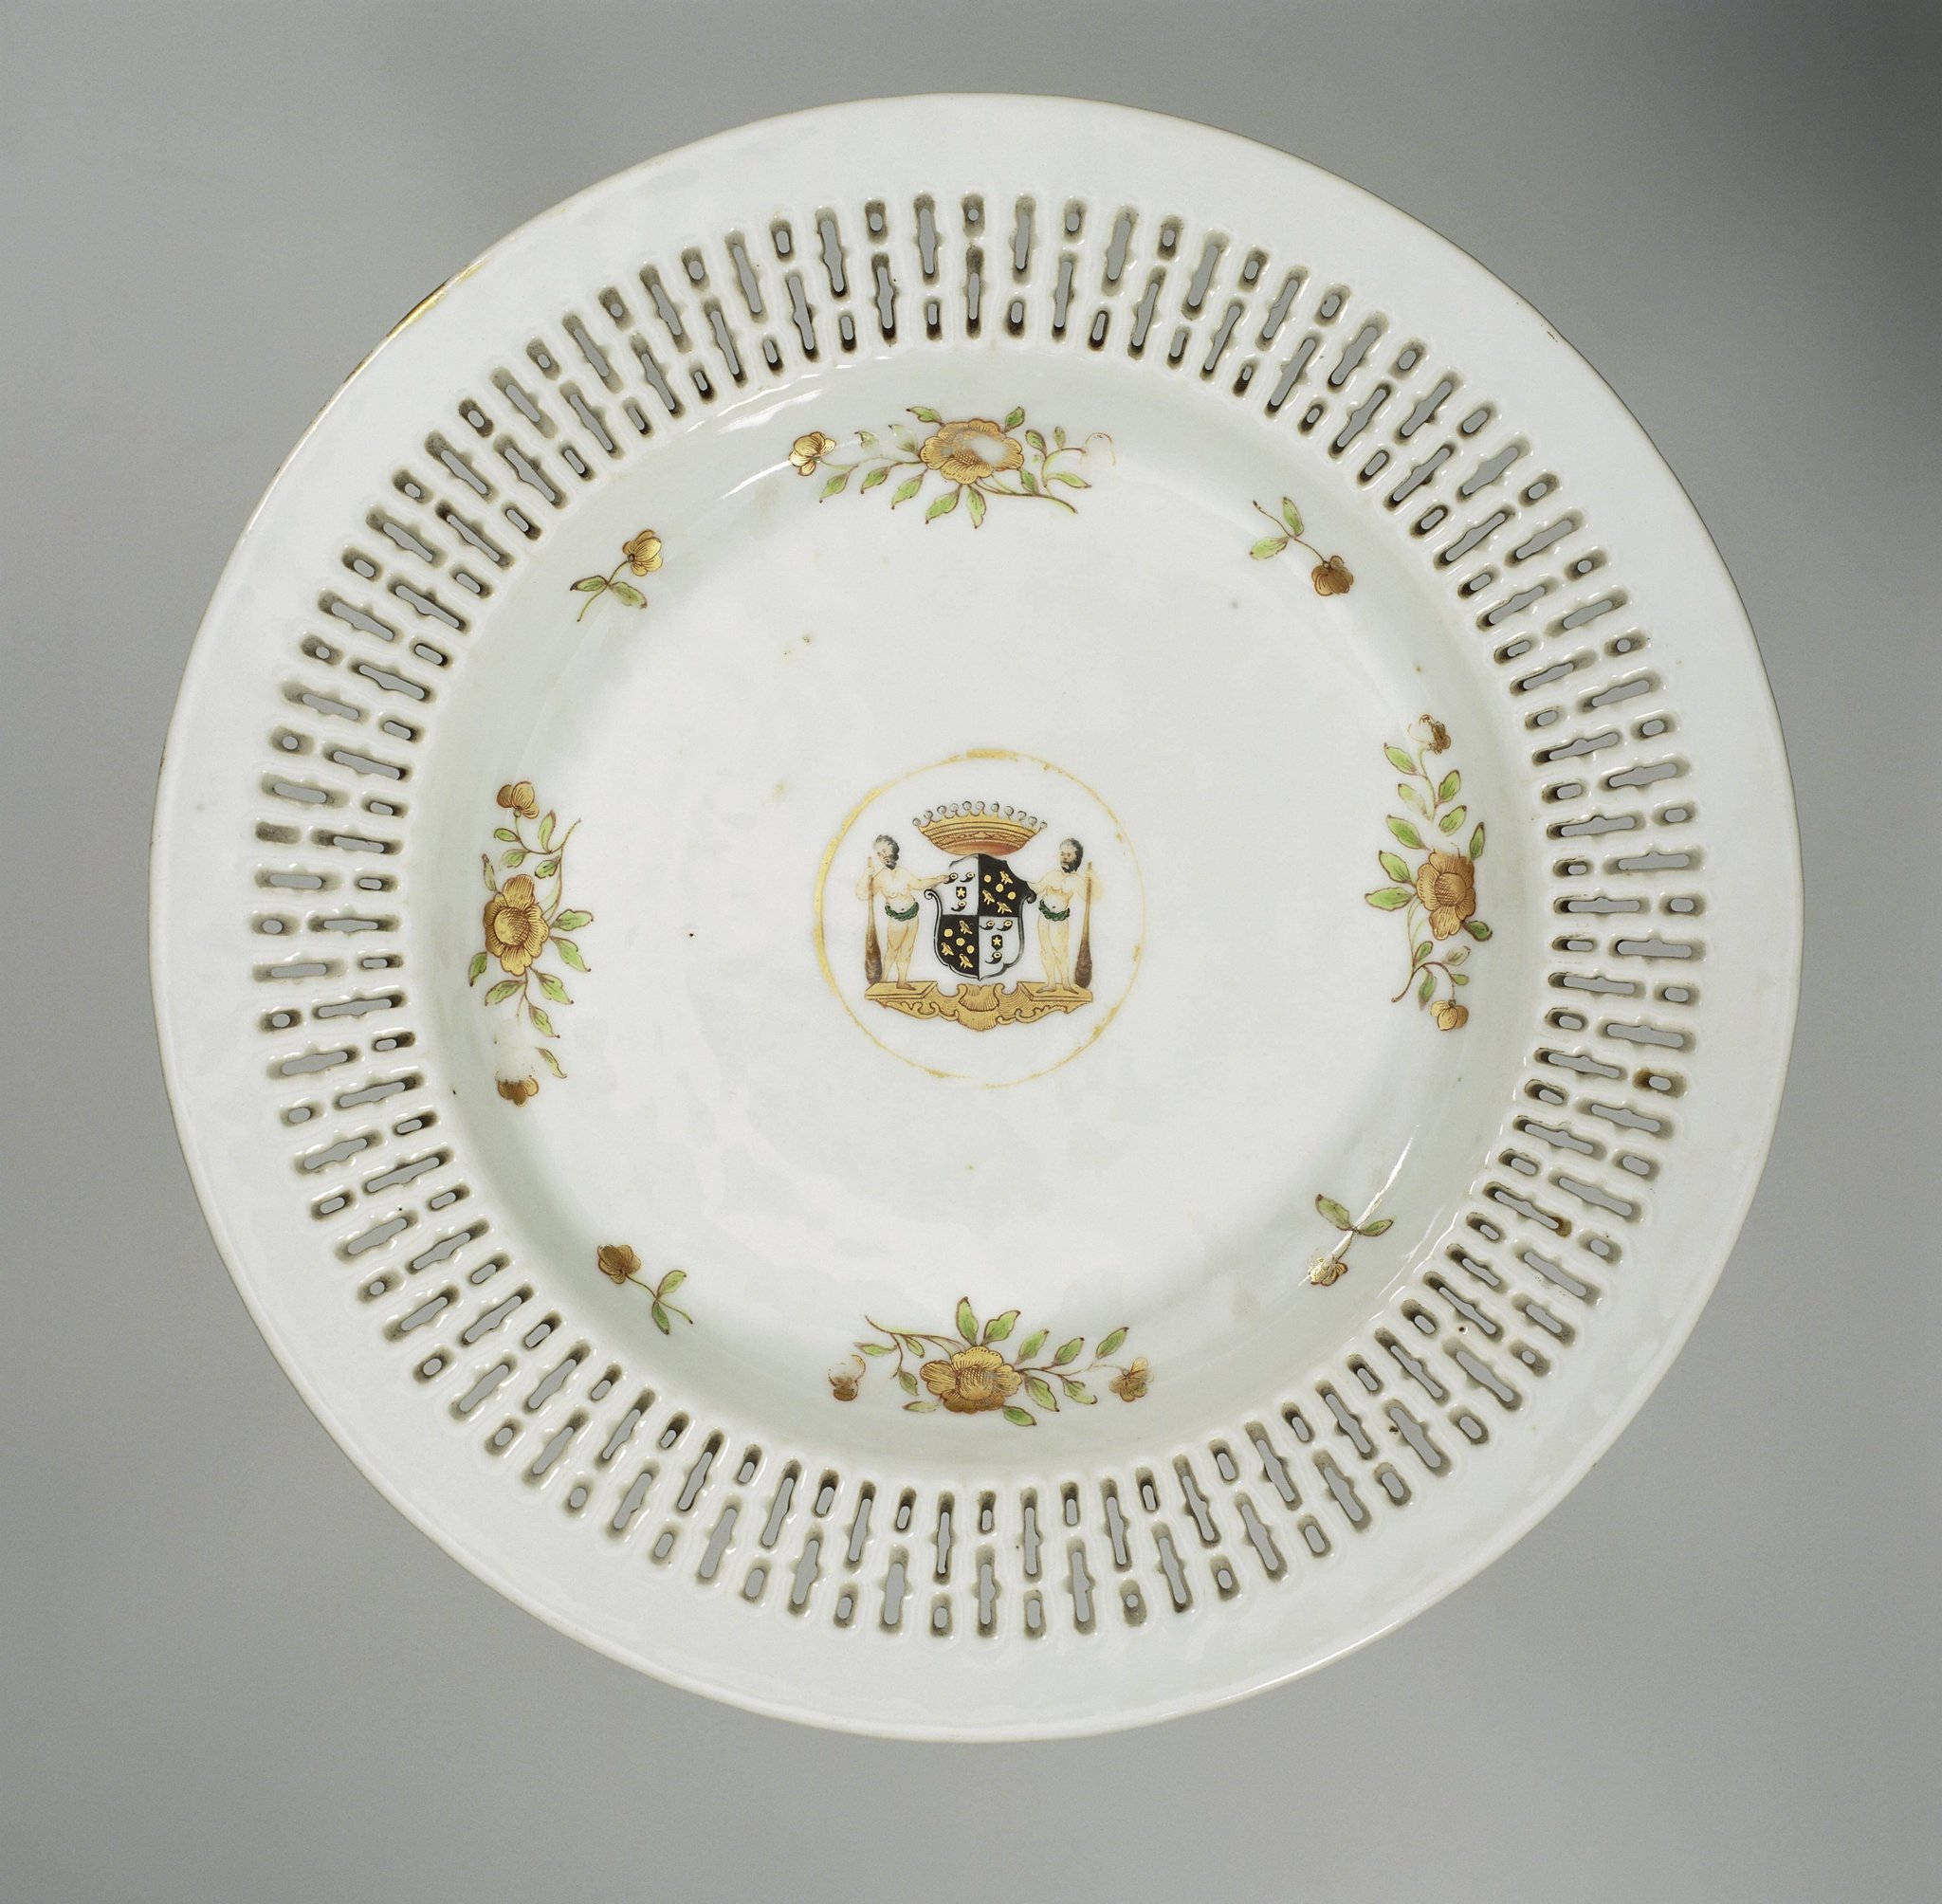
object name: plate dish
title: Plate with the arms of the Cornets de Groot family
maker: Anonymous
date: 1780-1790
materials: glaze, gold, paint, porcelain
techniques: embroidery, firing, gilding, turning, vitrification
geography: china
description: Bord van porselein met opengewerkte (ajourwerk) rand, beschilderd op het glazuur in rood, groen, bruin, zwart en goud. Op het plat in een medaillon het wapen van de familie Cornets de Groot in zwart en goud. Het wapen is verdeeld in vier delen: 1. en 4. drie hoorns met in het midden een hartschild met een zwarte achtergrond en een gouden ster, 2. en 3. op een zwarte achtergrond drie gouden byzantijnen of ballen en drie kraaien. Boven het wapen is een kroon met elf parels afgebeeld. Aan weerszijden van het schild staan twee wildemannen die een knots vasthouden. Het geheel wordt ondersteund door een voetstuk in rococo-stijl. Op de wand vier bloemtakken en vier losse bloemen. Wapenporselein met emailkleuren.